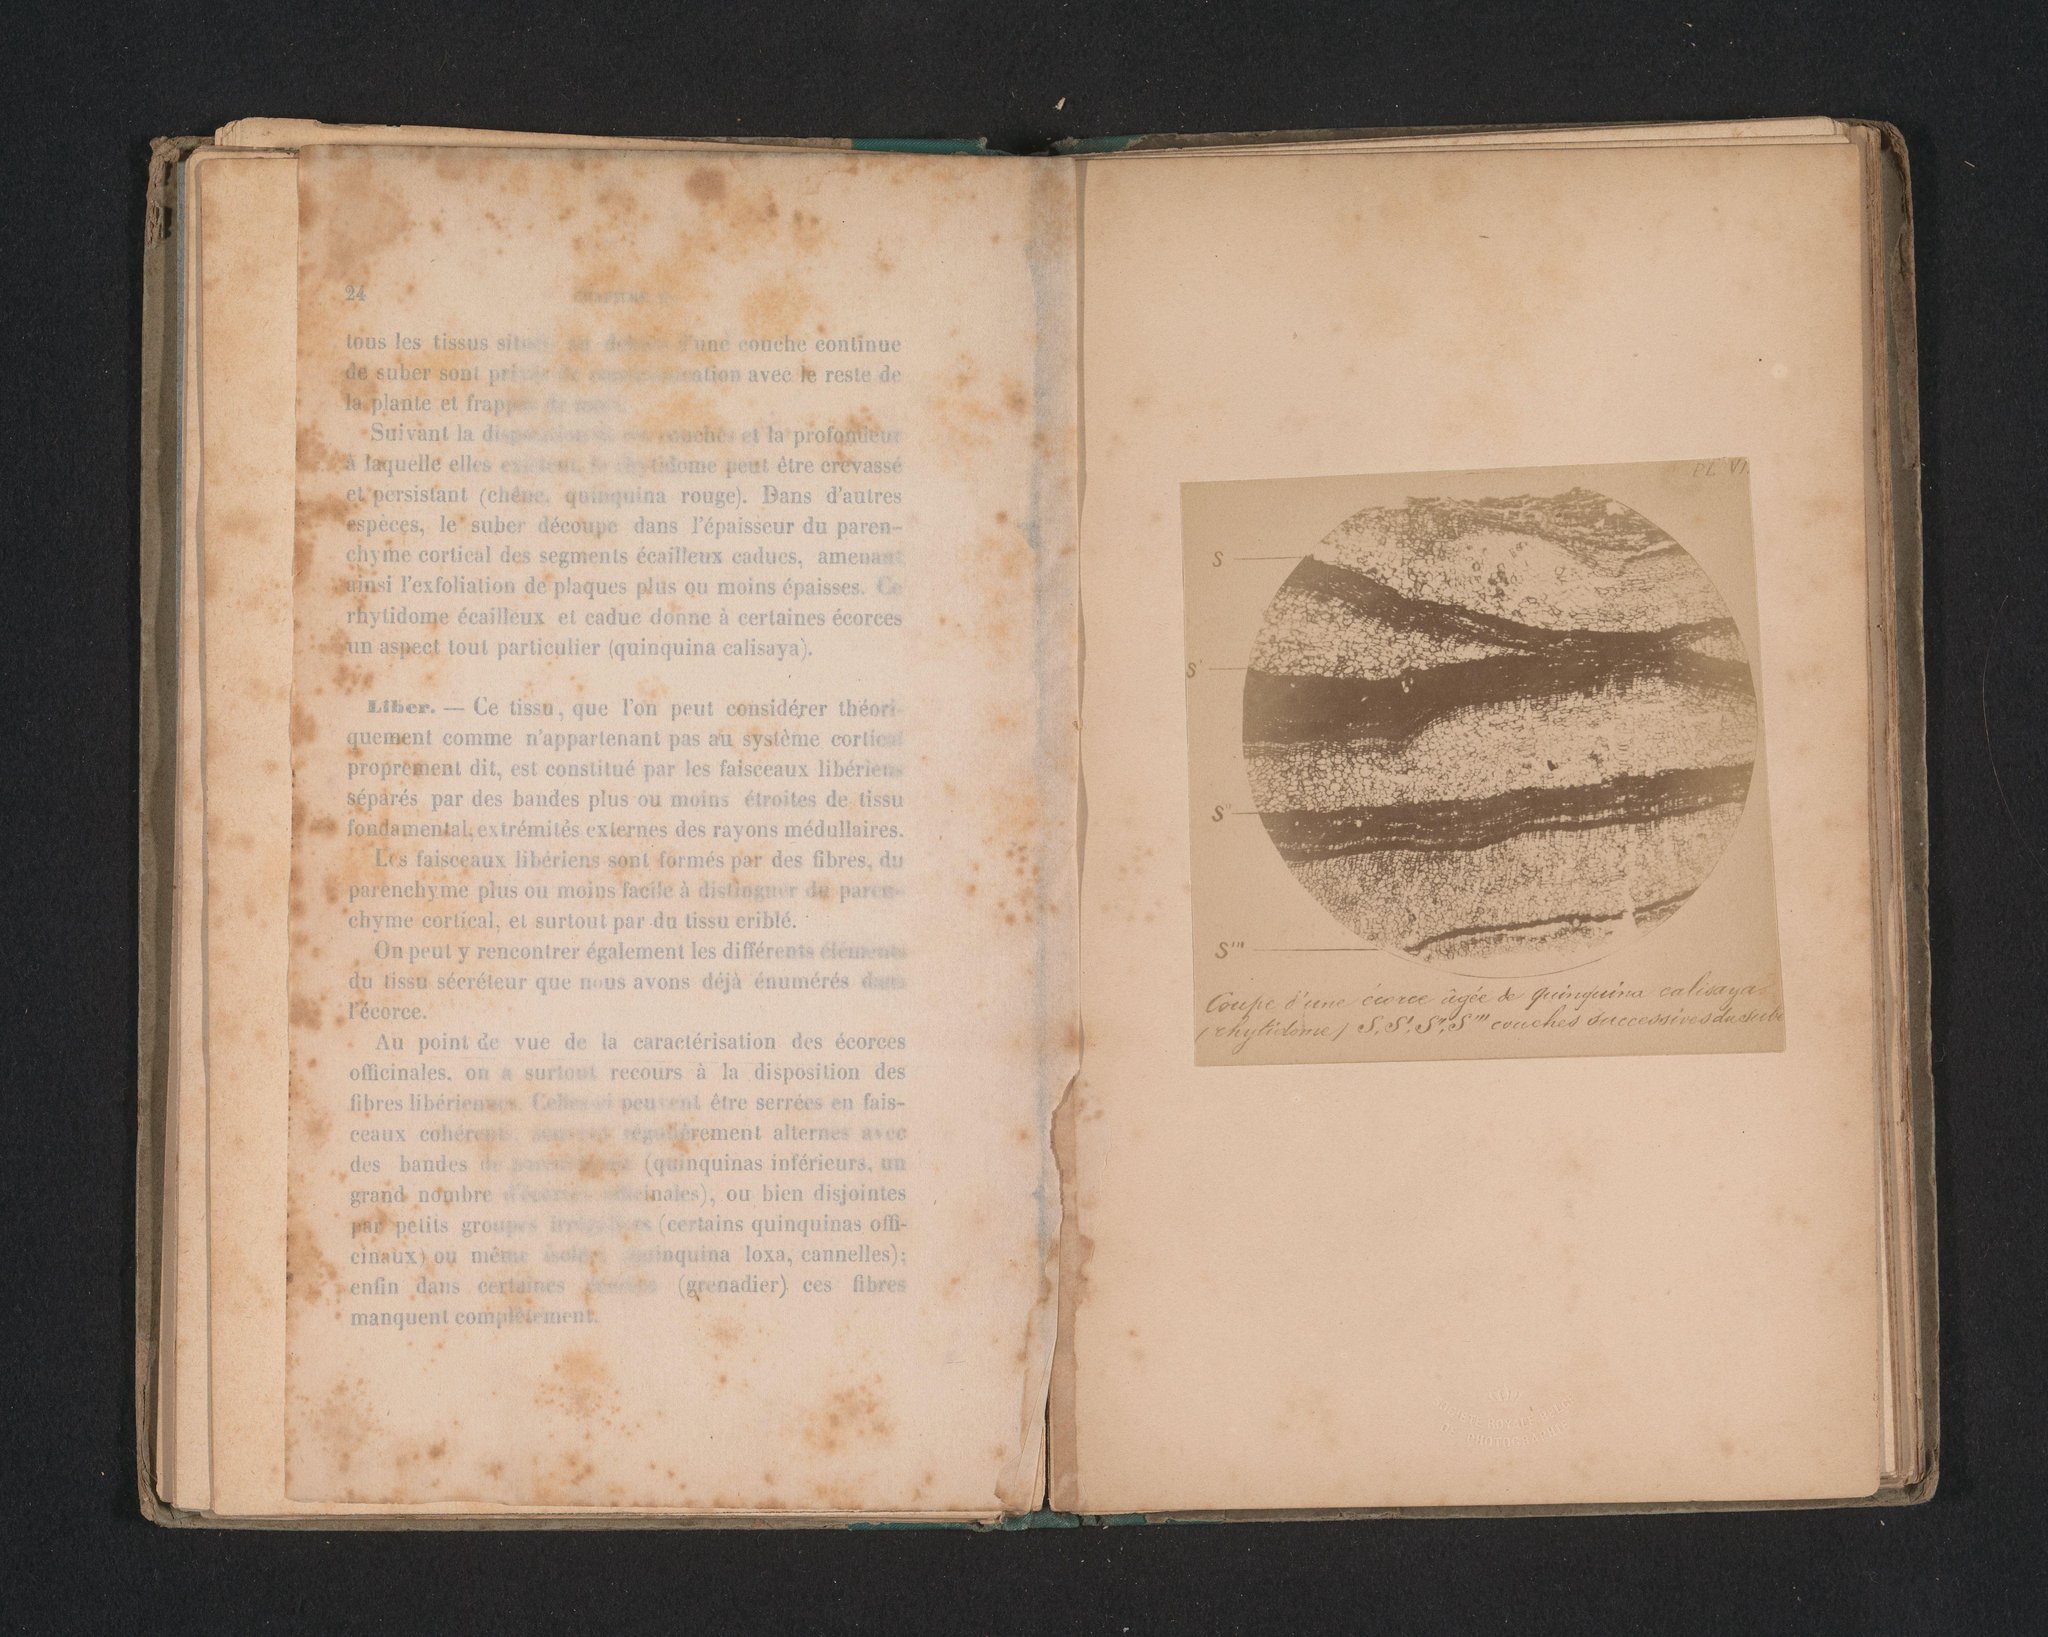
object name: photograph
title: Dwarsdoorsnede van de oude schors van cinchona calisaya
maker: Anonymous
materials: photographic support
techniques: albumen print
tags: plants; vegetation